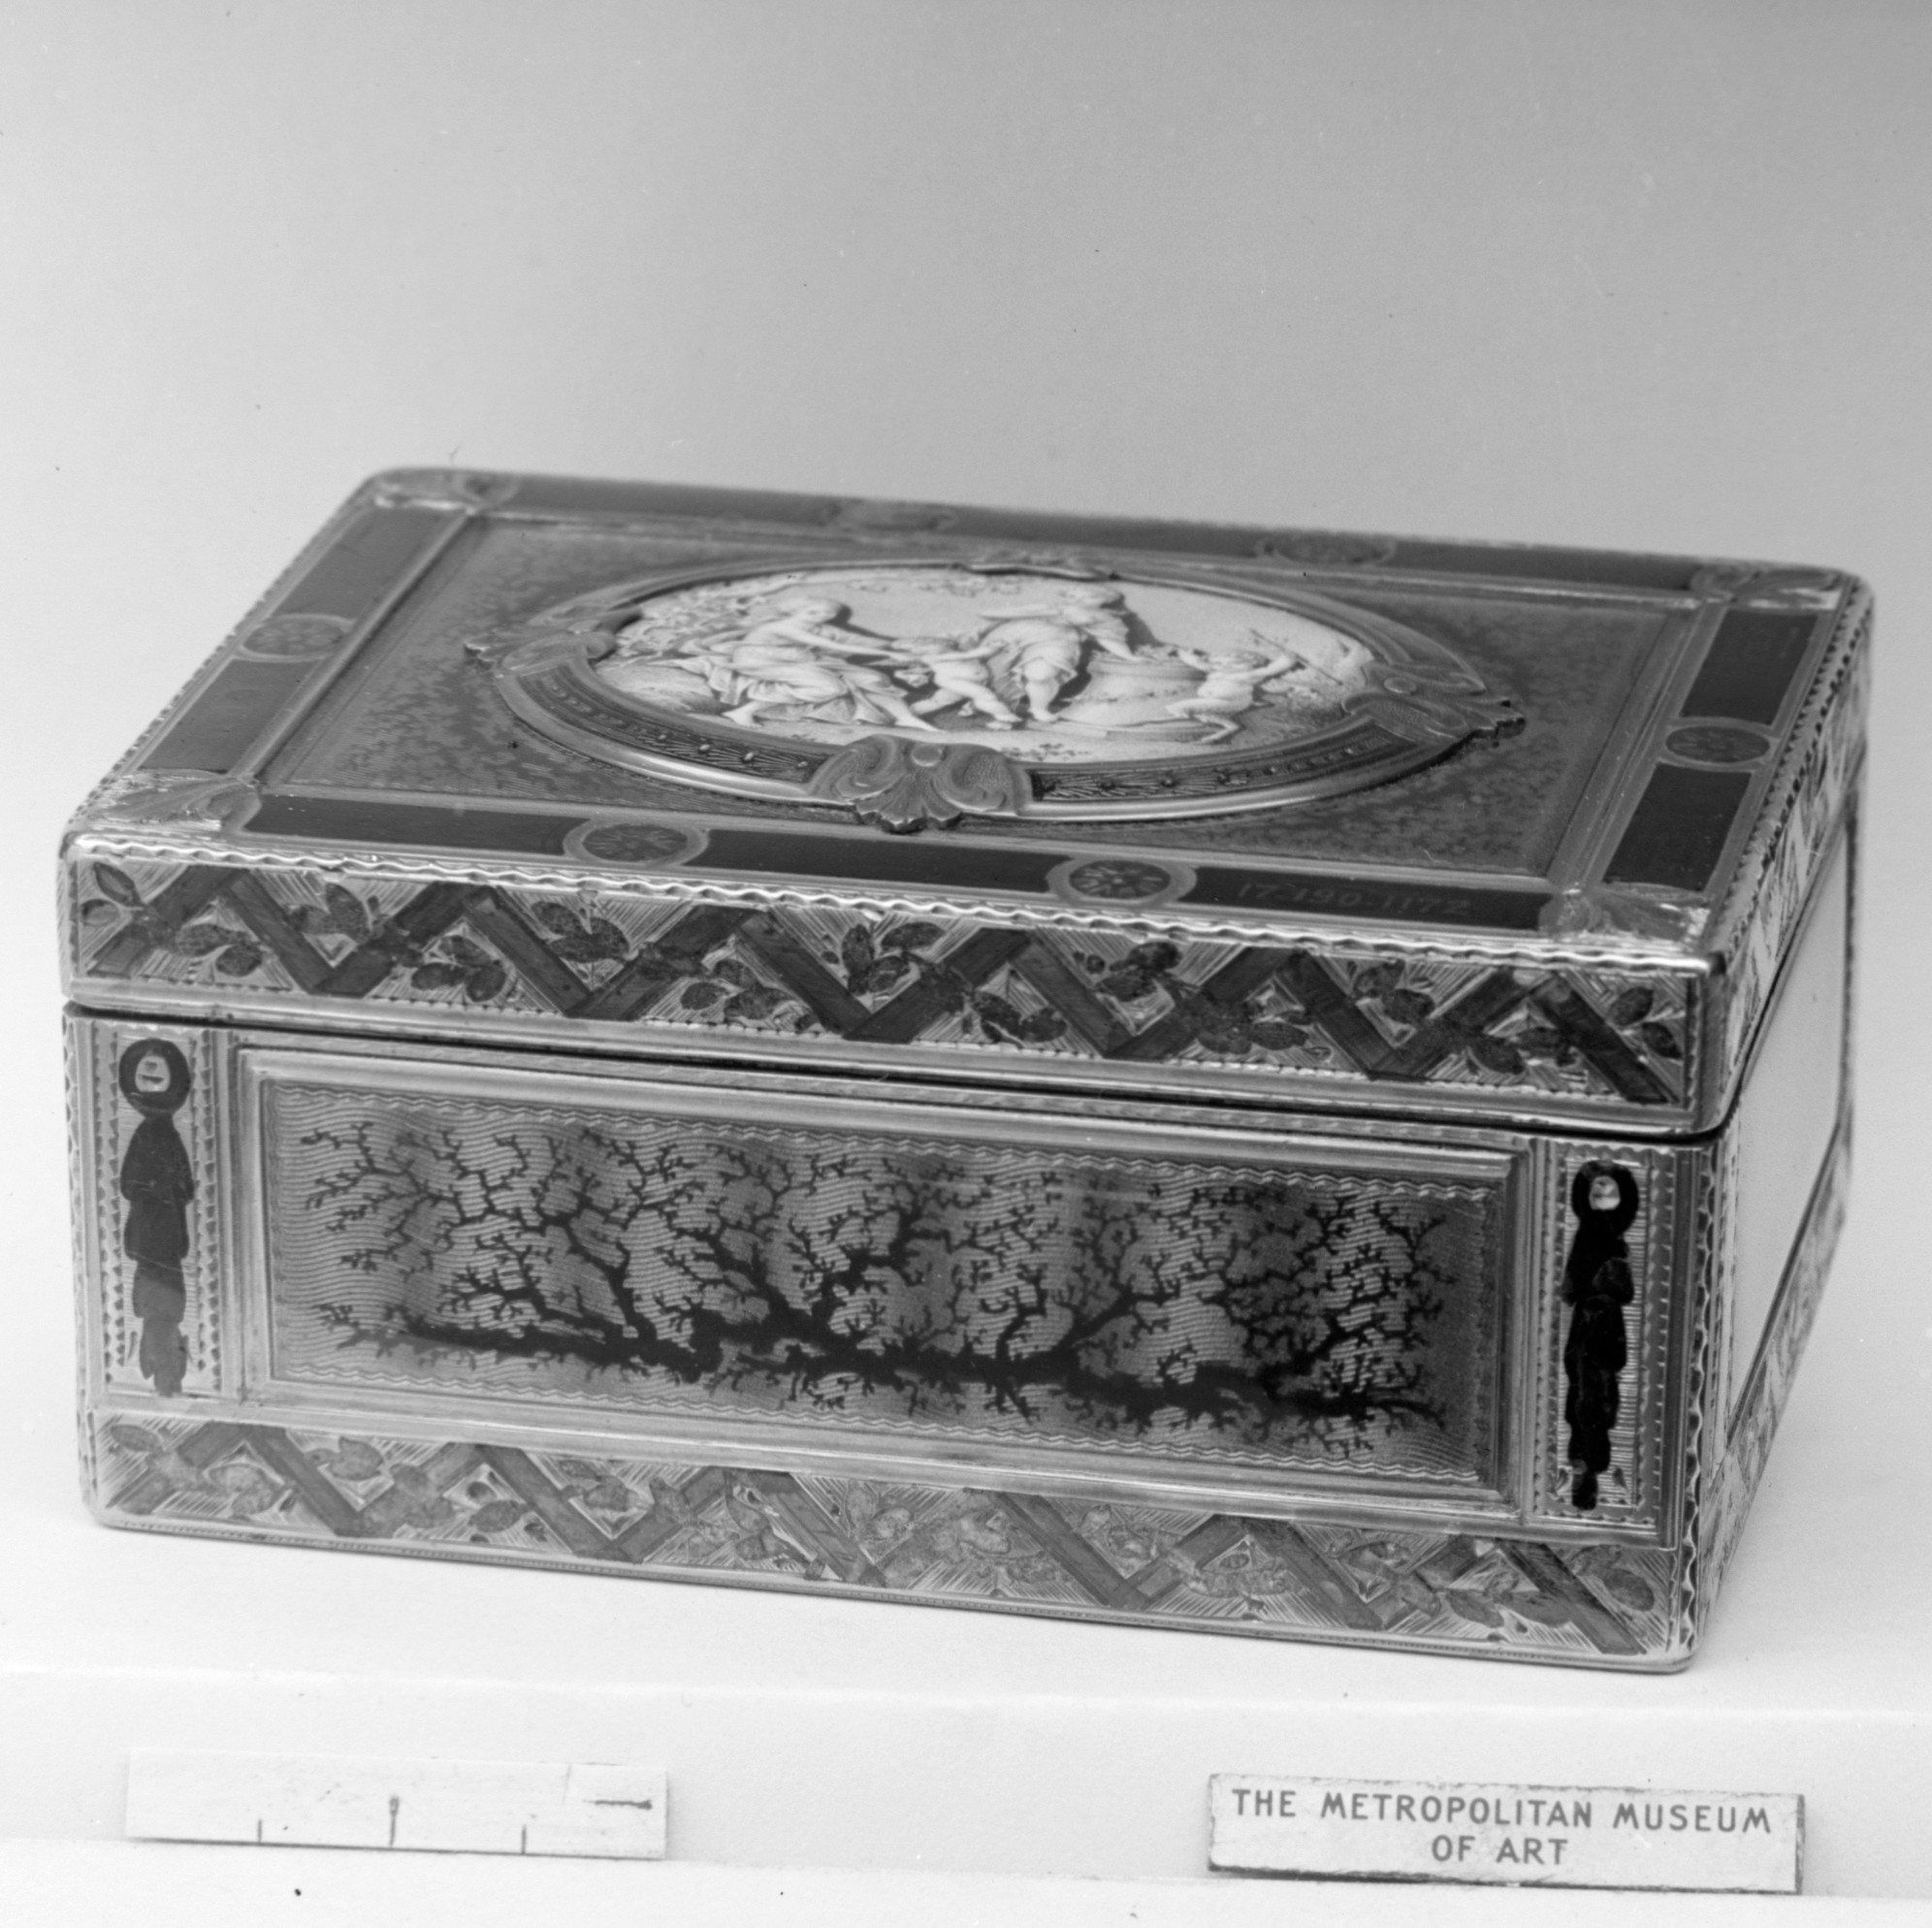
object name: snuffbox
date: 1801-1900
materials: enamel, gold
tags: human figures,trees